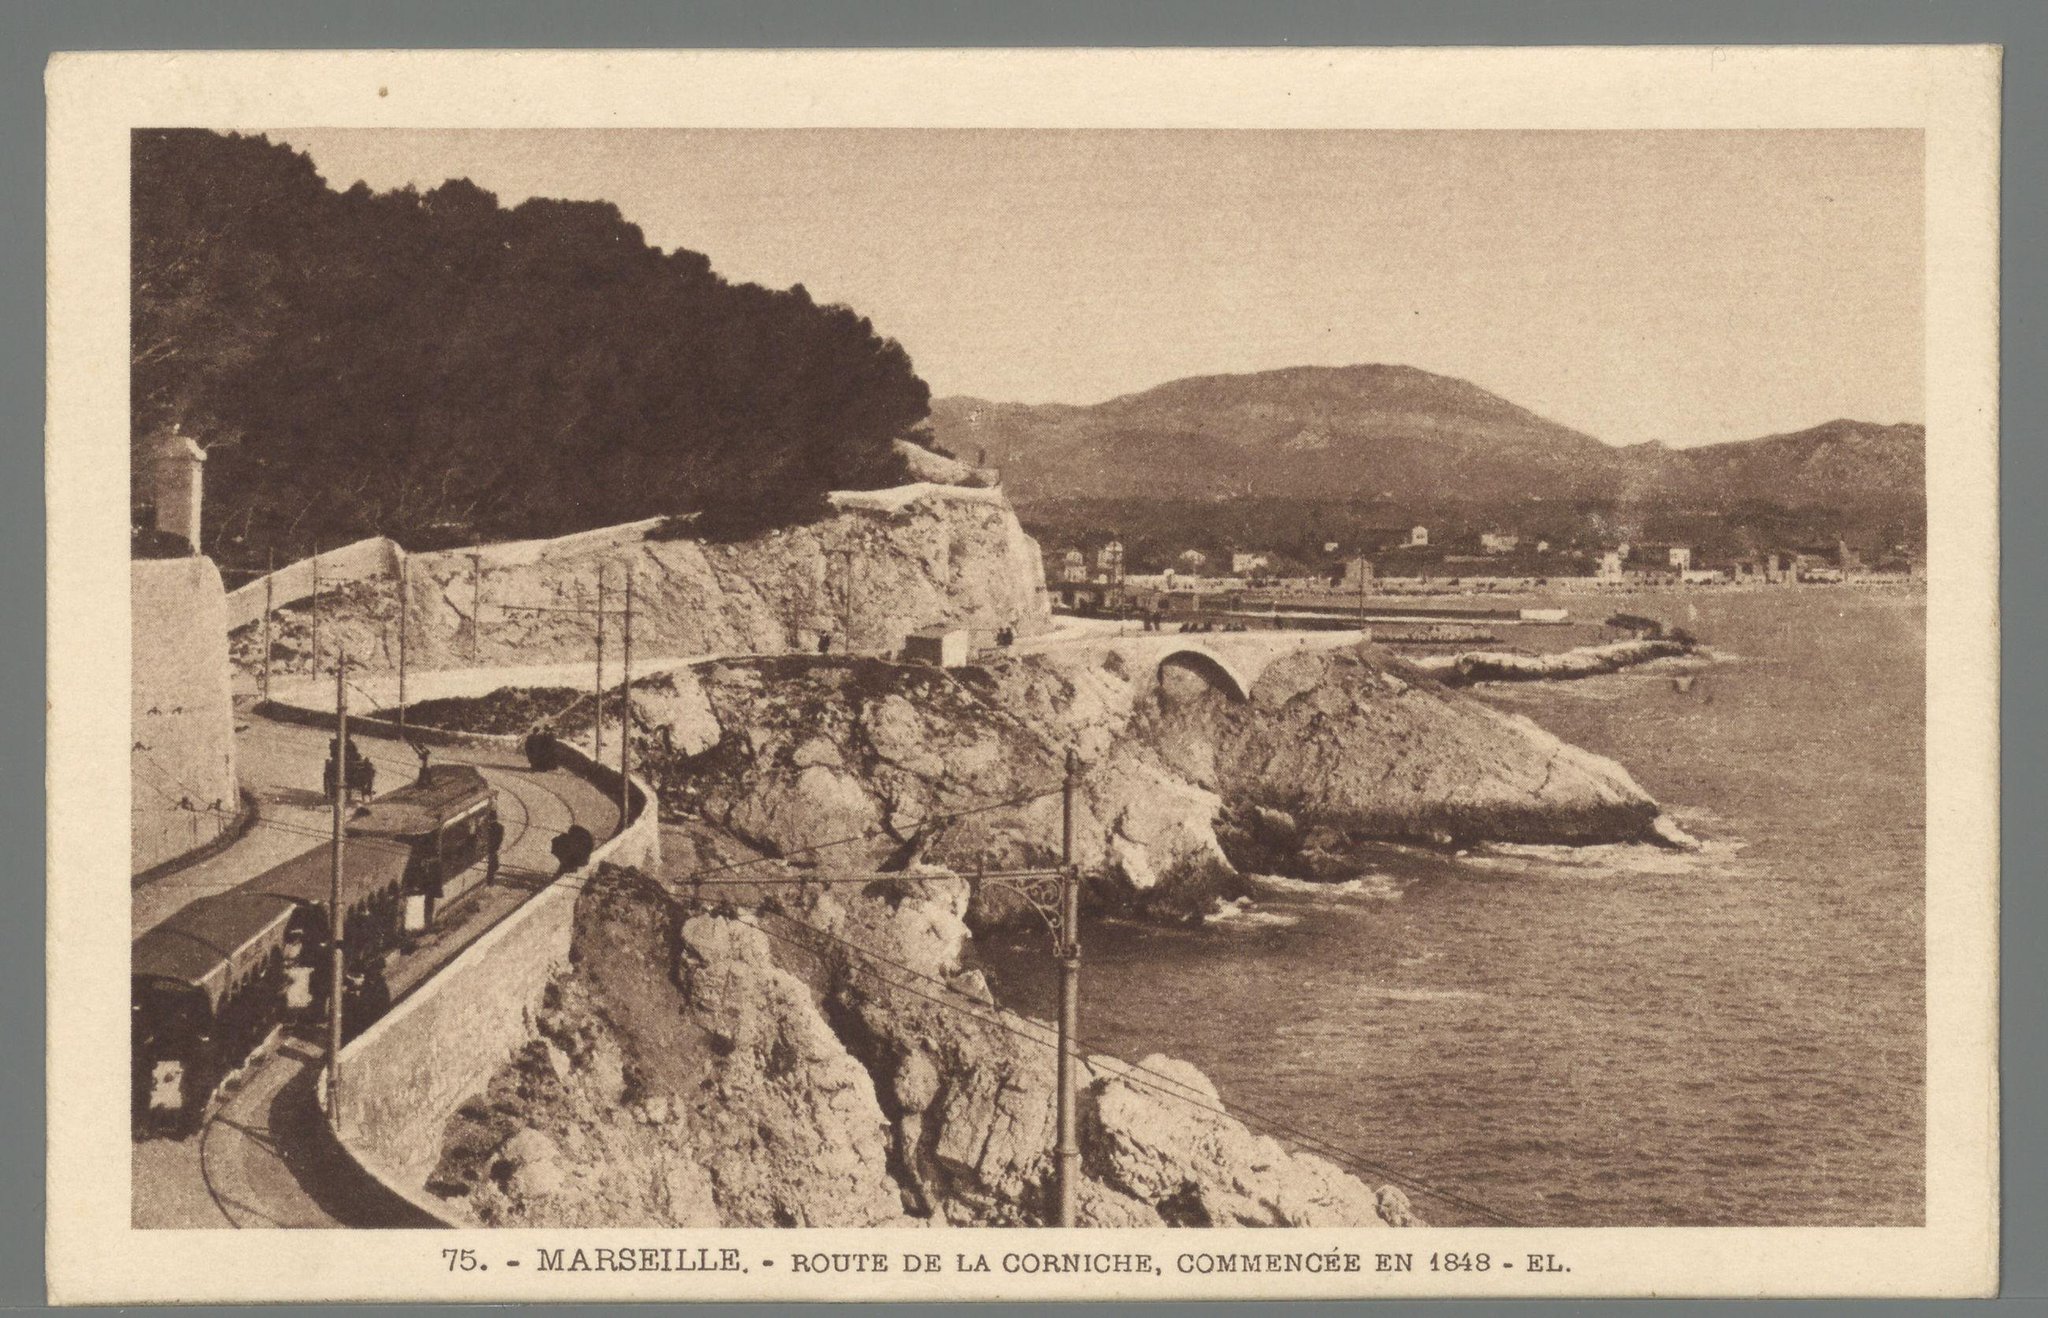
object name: ansichtkaart, prentbriefkaart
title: Marseille. Route de la Corniche, commencée en 1848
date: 1903-1913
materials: cardboard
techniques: rotogravure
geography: marseille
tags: rocky coast, sea (seascape), marseille